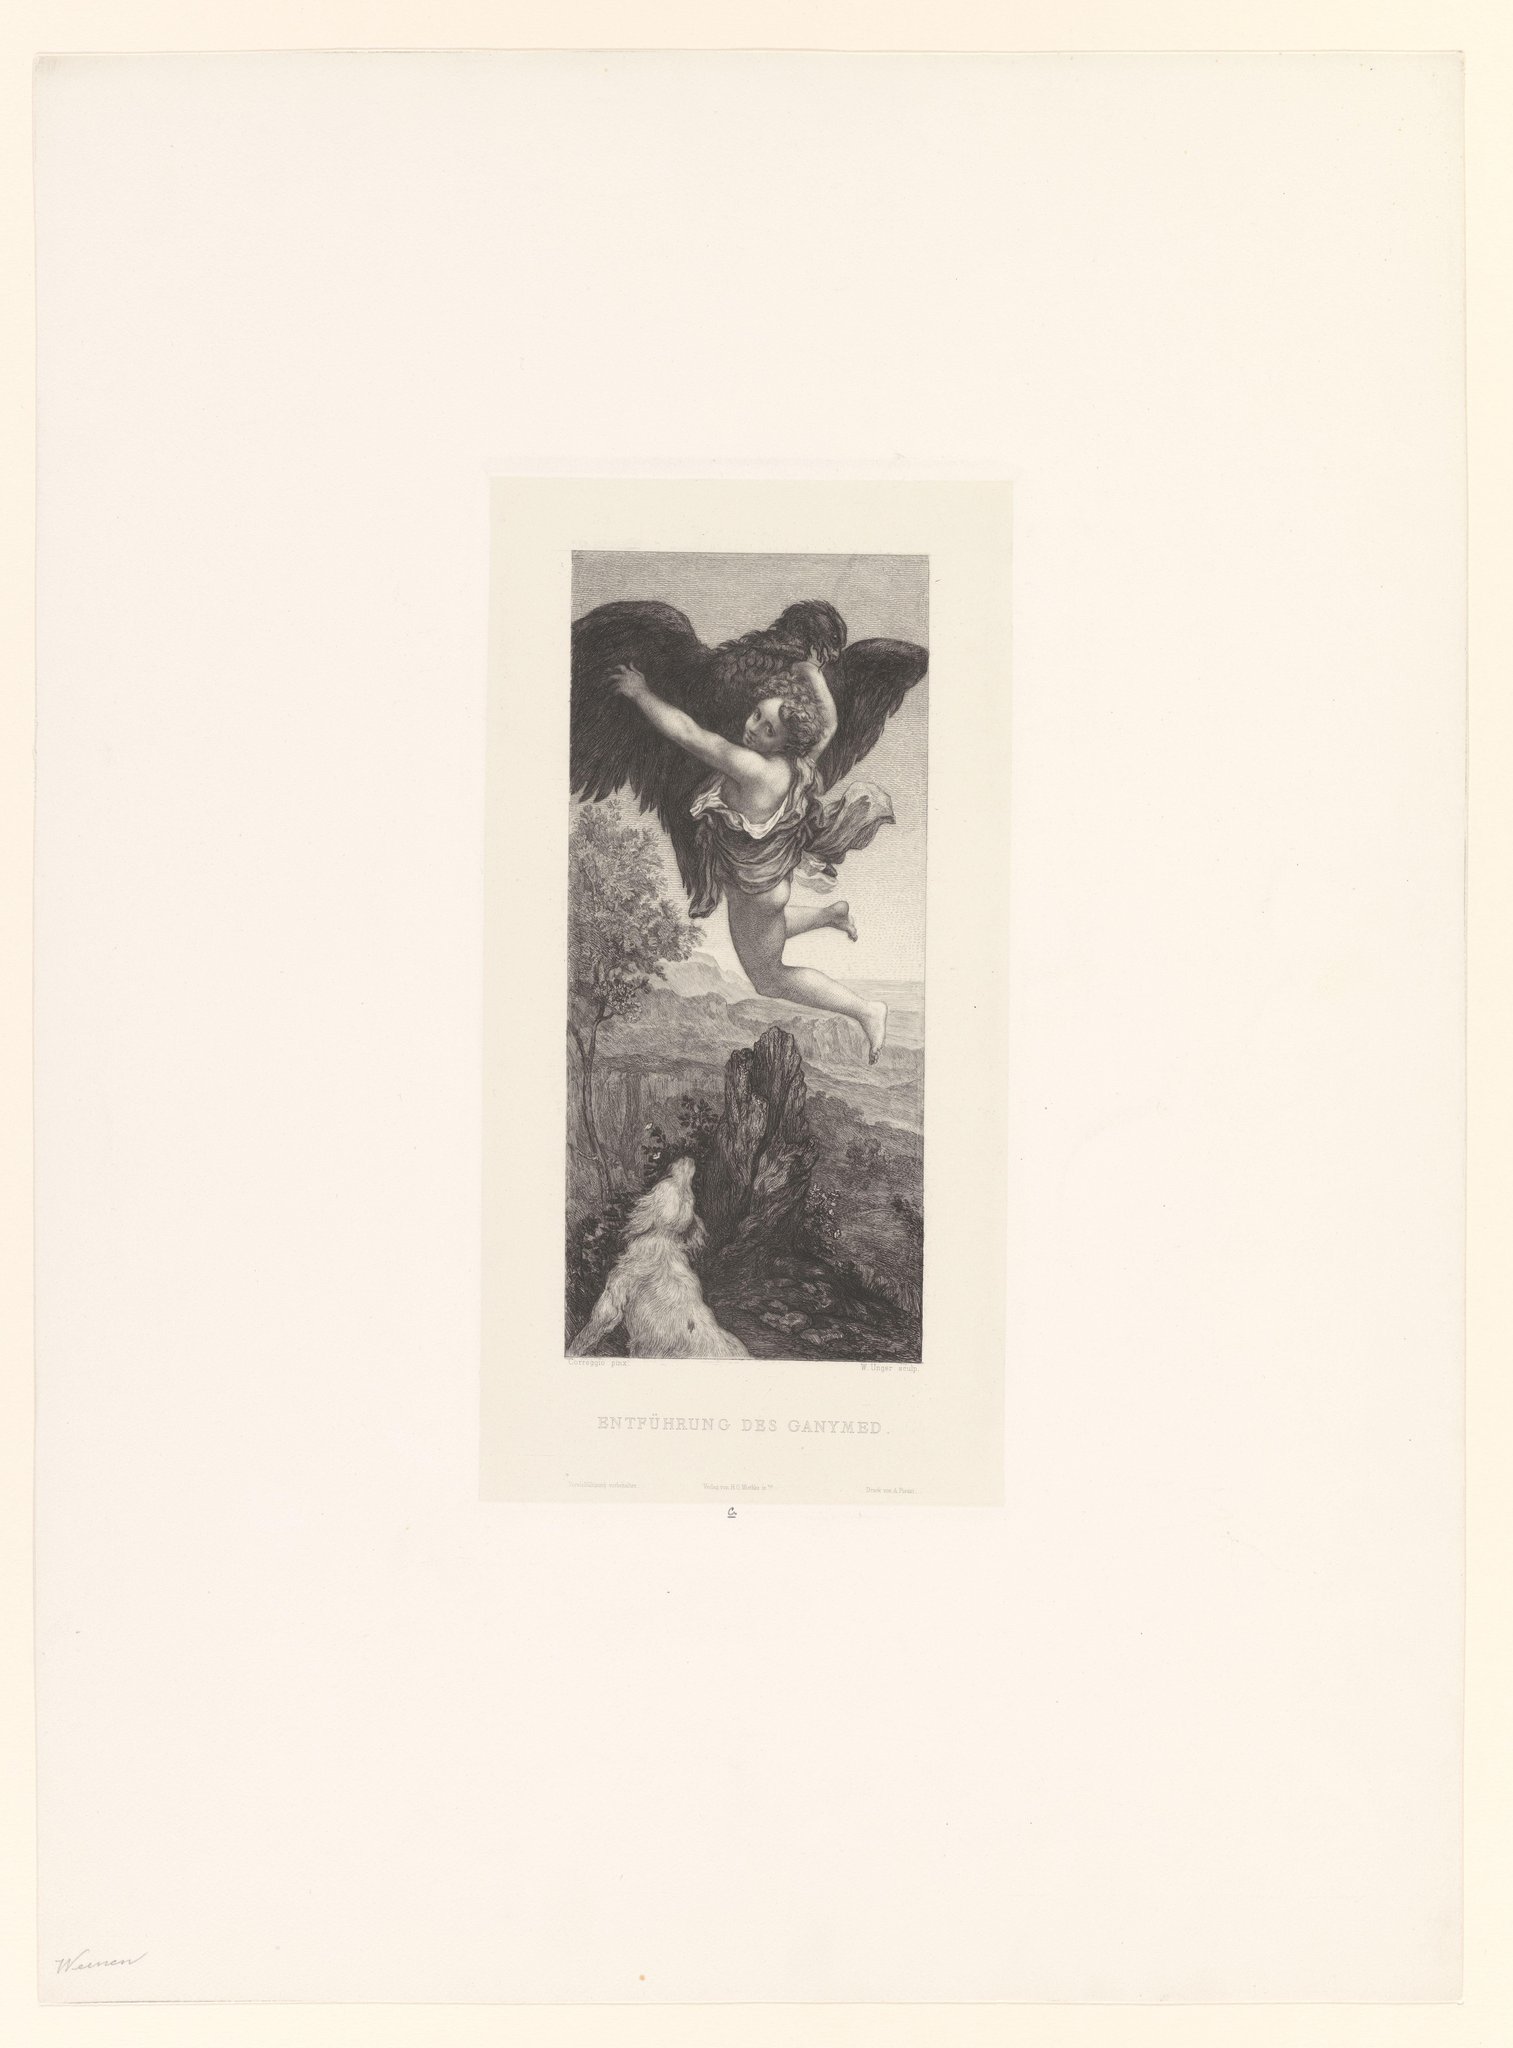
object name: print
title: Entführung des Ganymed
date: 1861-1889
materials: paper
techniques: etching, intaglio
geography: vienna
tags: (story of) ganymede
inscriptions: collector's mark: Lugt 2228